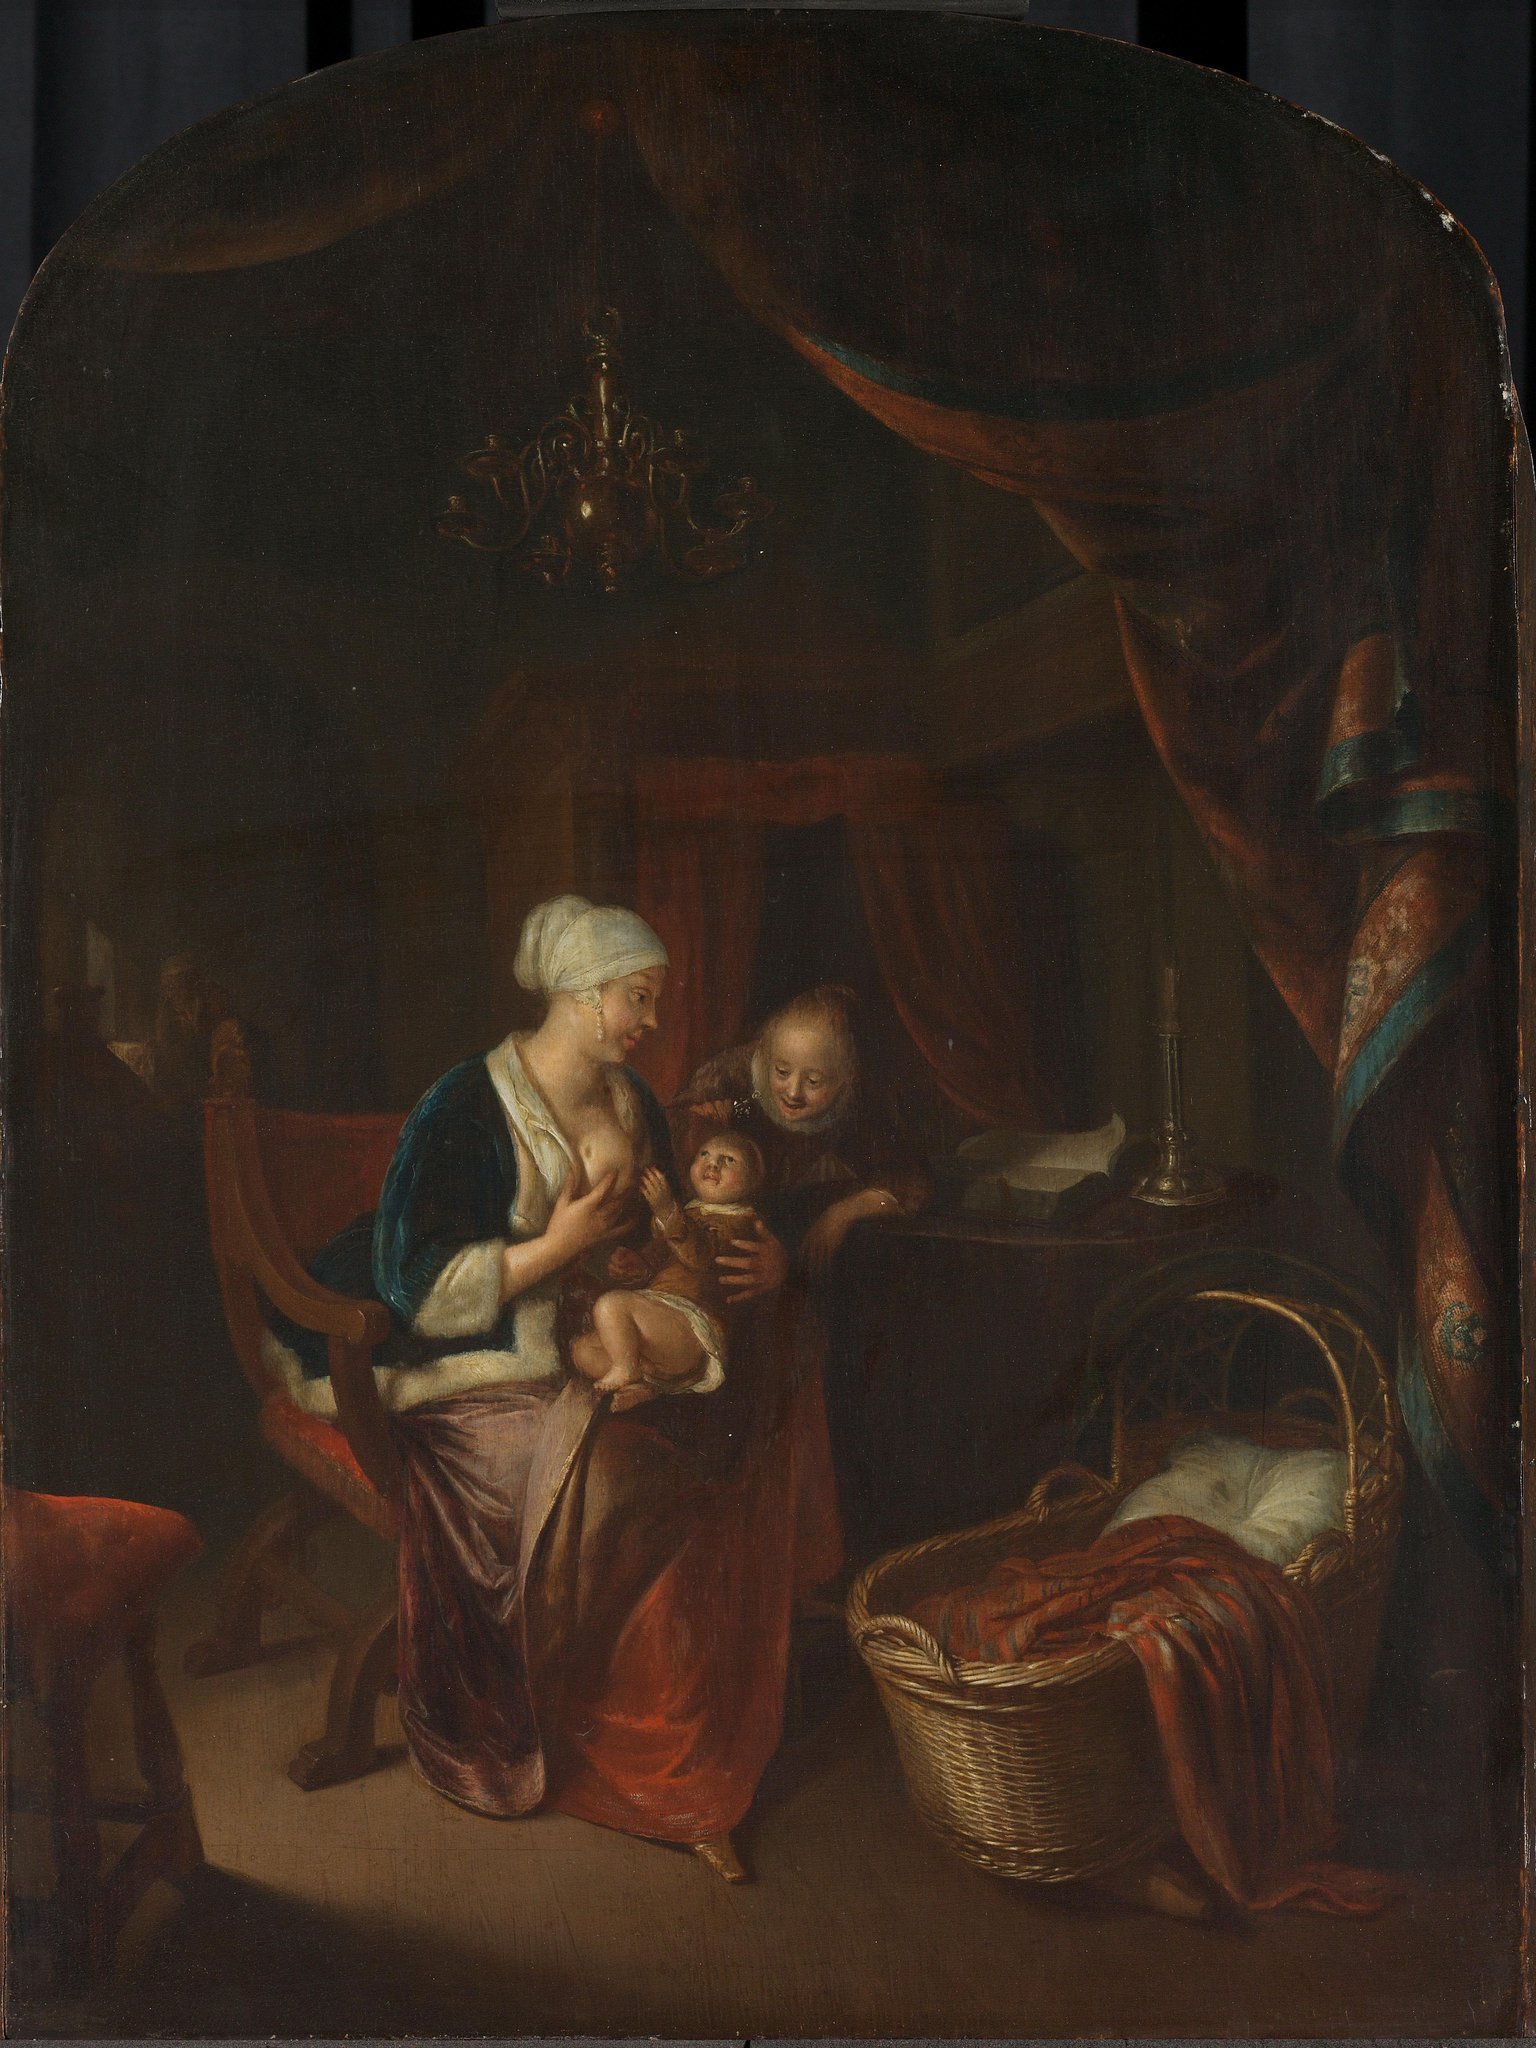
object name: painting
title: A Mother giving her Child the Breast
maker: domenicus van tol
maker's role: painter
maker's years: 1625-1676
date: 1660-1676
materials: oil, panel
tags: nursing, suckling, cradle, crib, mother and baby or young child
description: Interieur met een moeder die haar kind de borst geeft. Een oudere dochter kijkt toe, rechts staat de wieg.